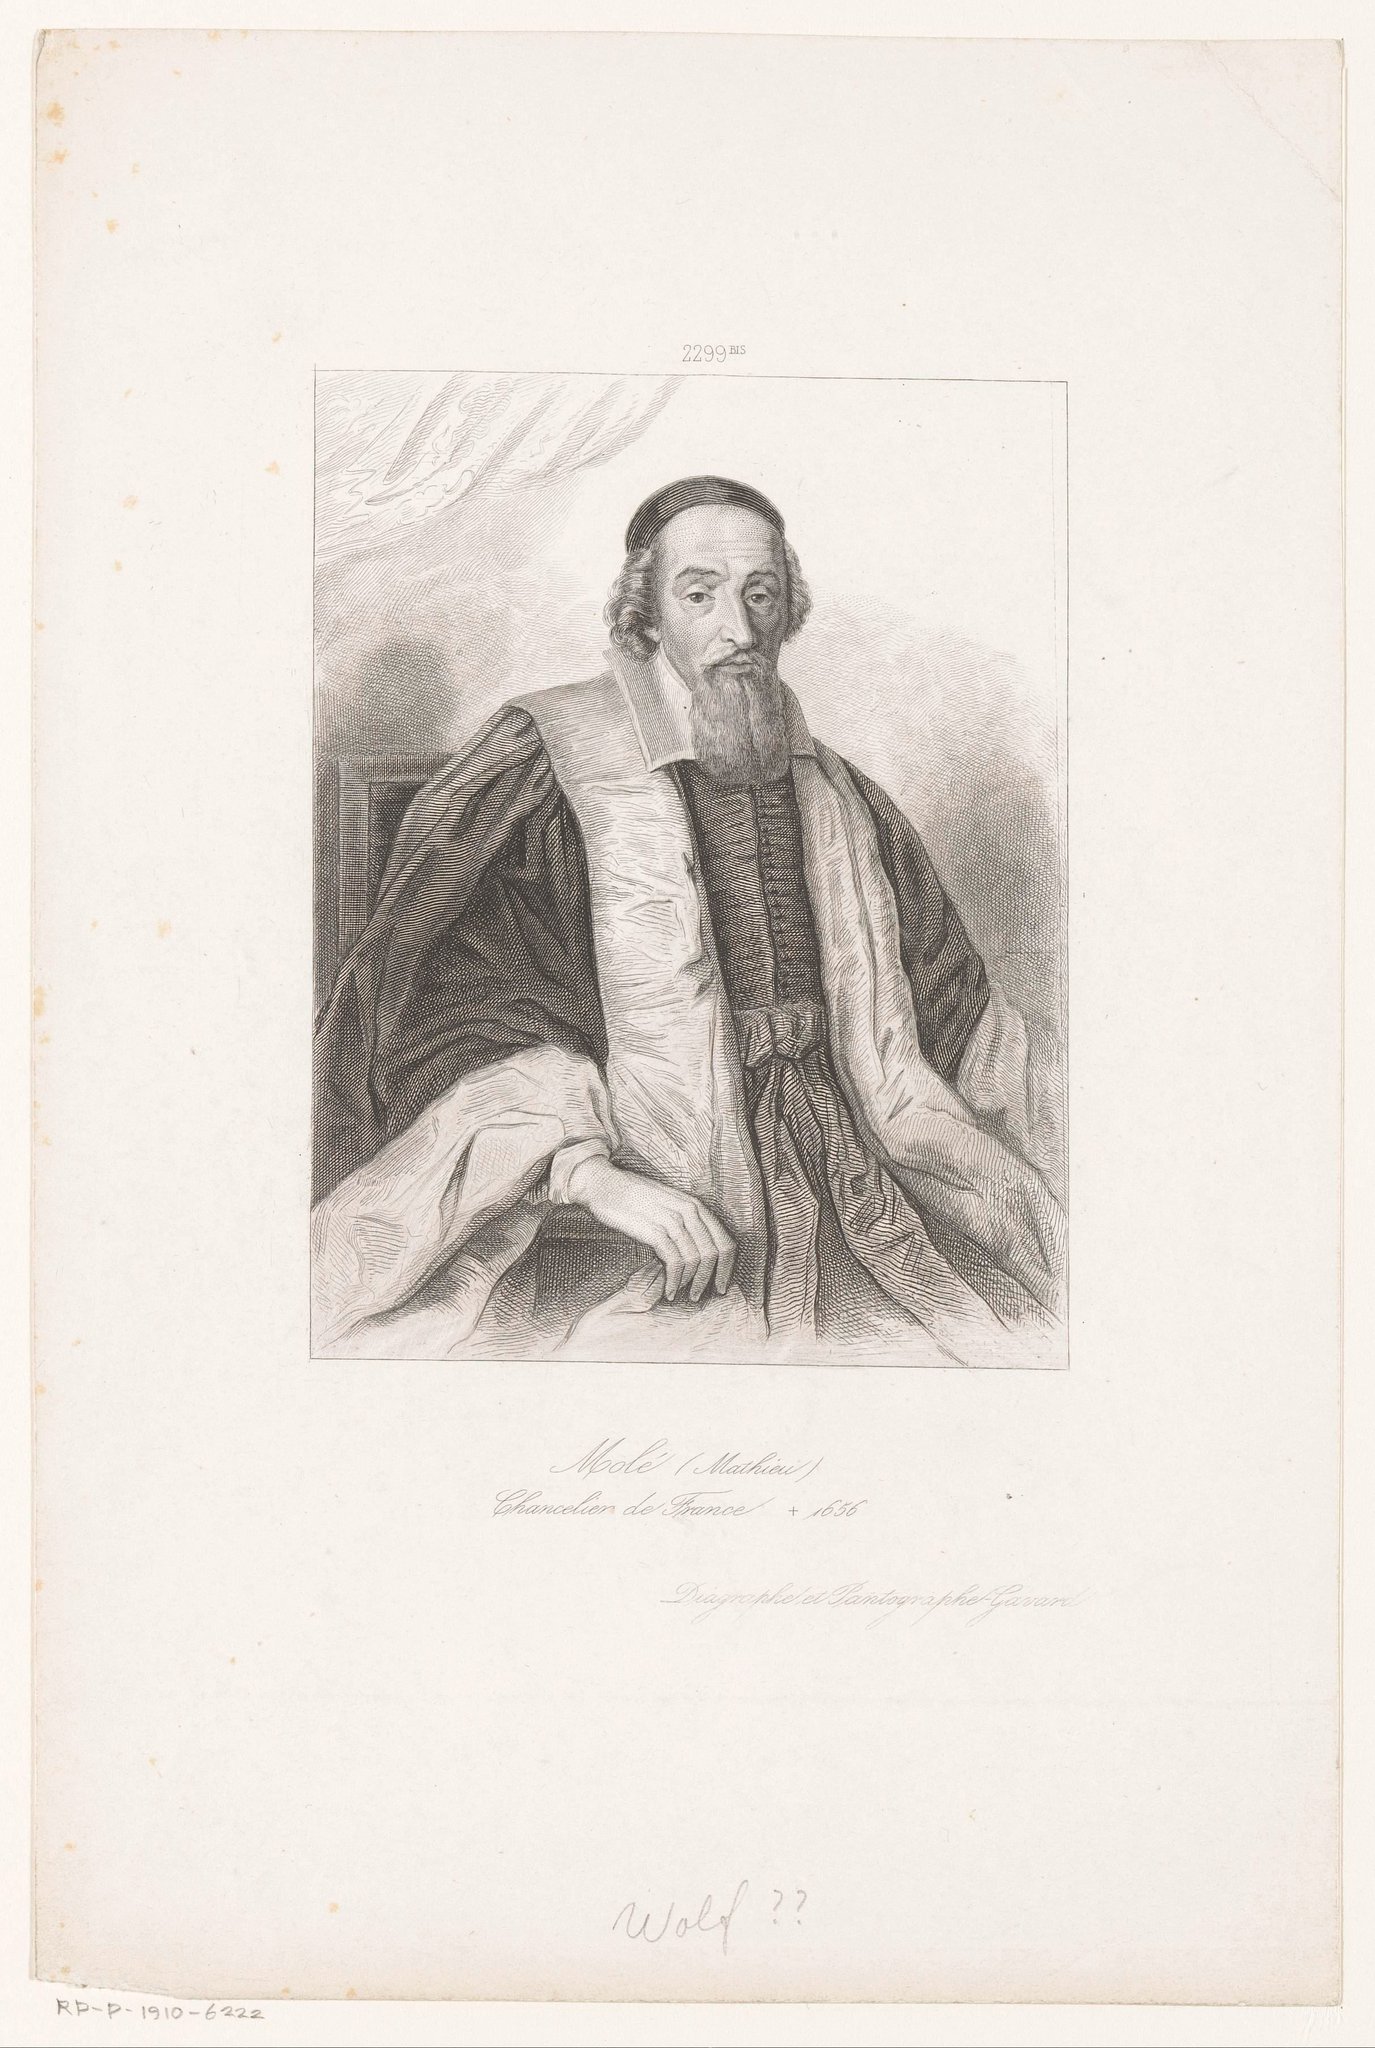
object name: print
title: Molé (Mathieu) (...)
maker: charles gavard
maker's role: print maker, publisher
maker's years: 1794-1871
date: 1838-1841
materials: paper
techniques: engraving, etching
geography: france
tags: official; civil servant; functionary (in general), historical persons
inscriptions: collector's mark: Lugt 2228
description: Prent uit: s.n. Galeries historiques de Versailles. Parijs: Charles Gavard, 1838-1841.